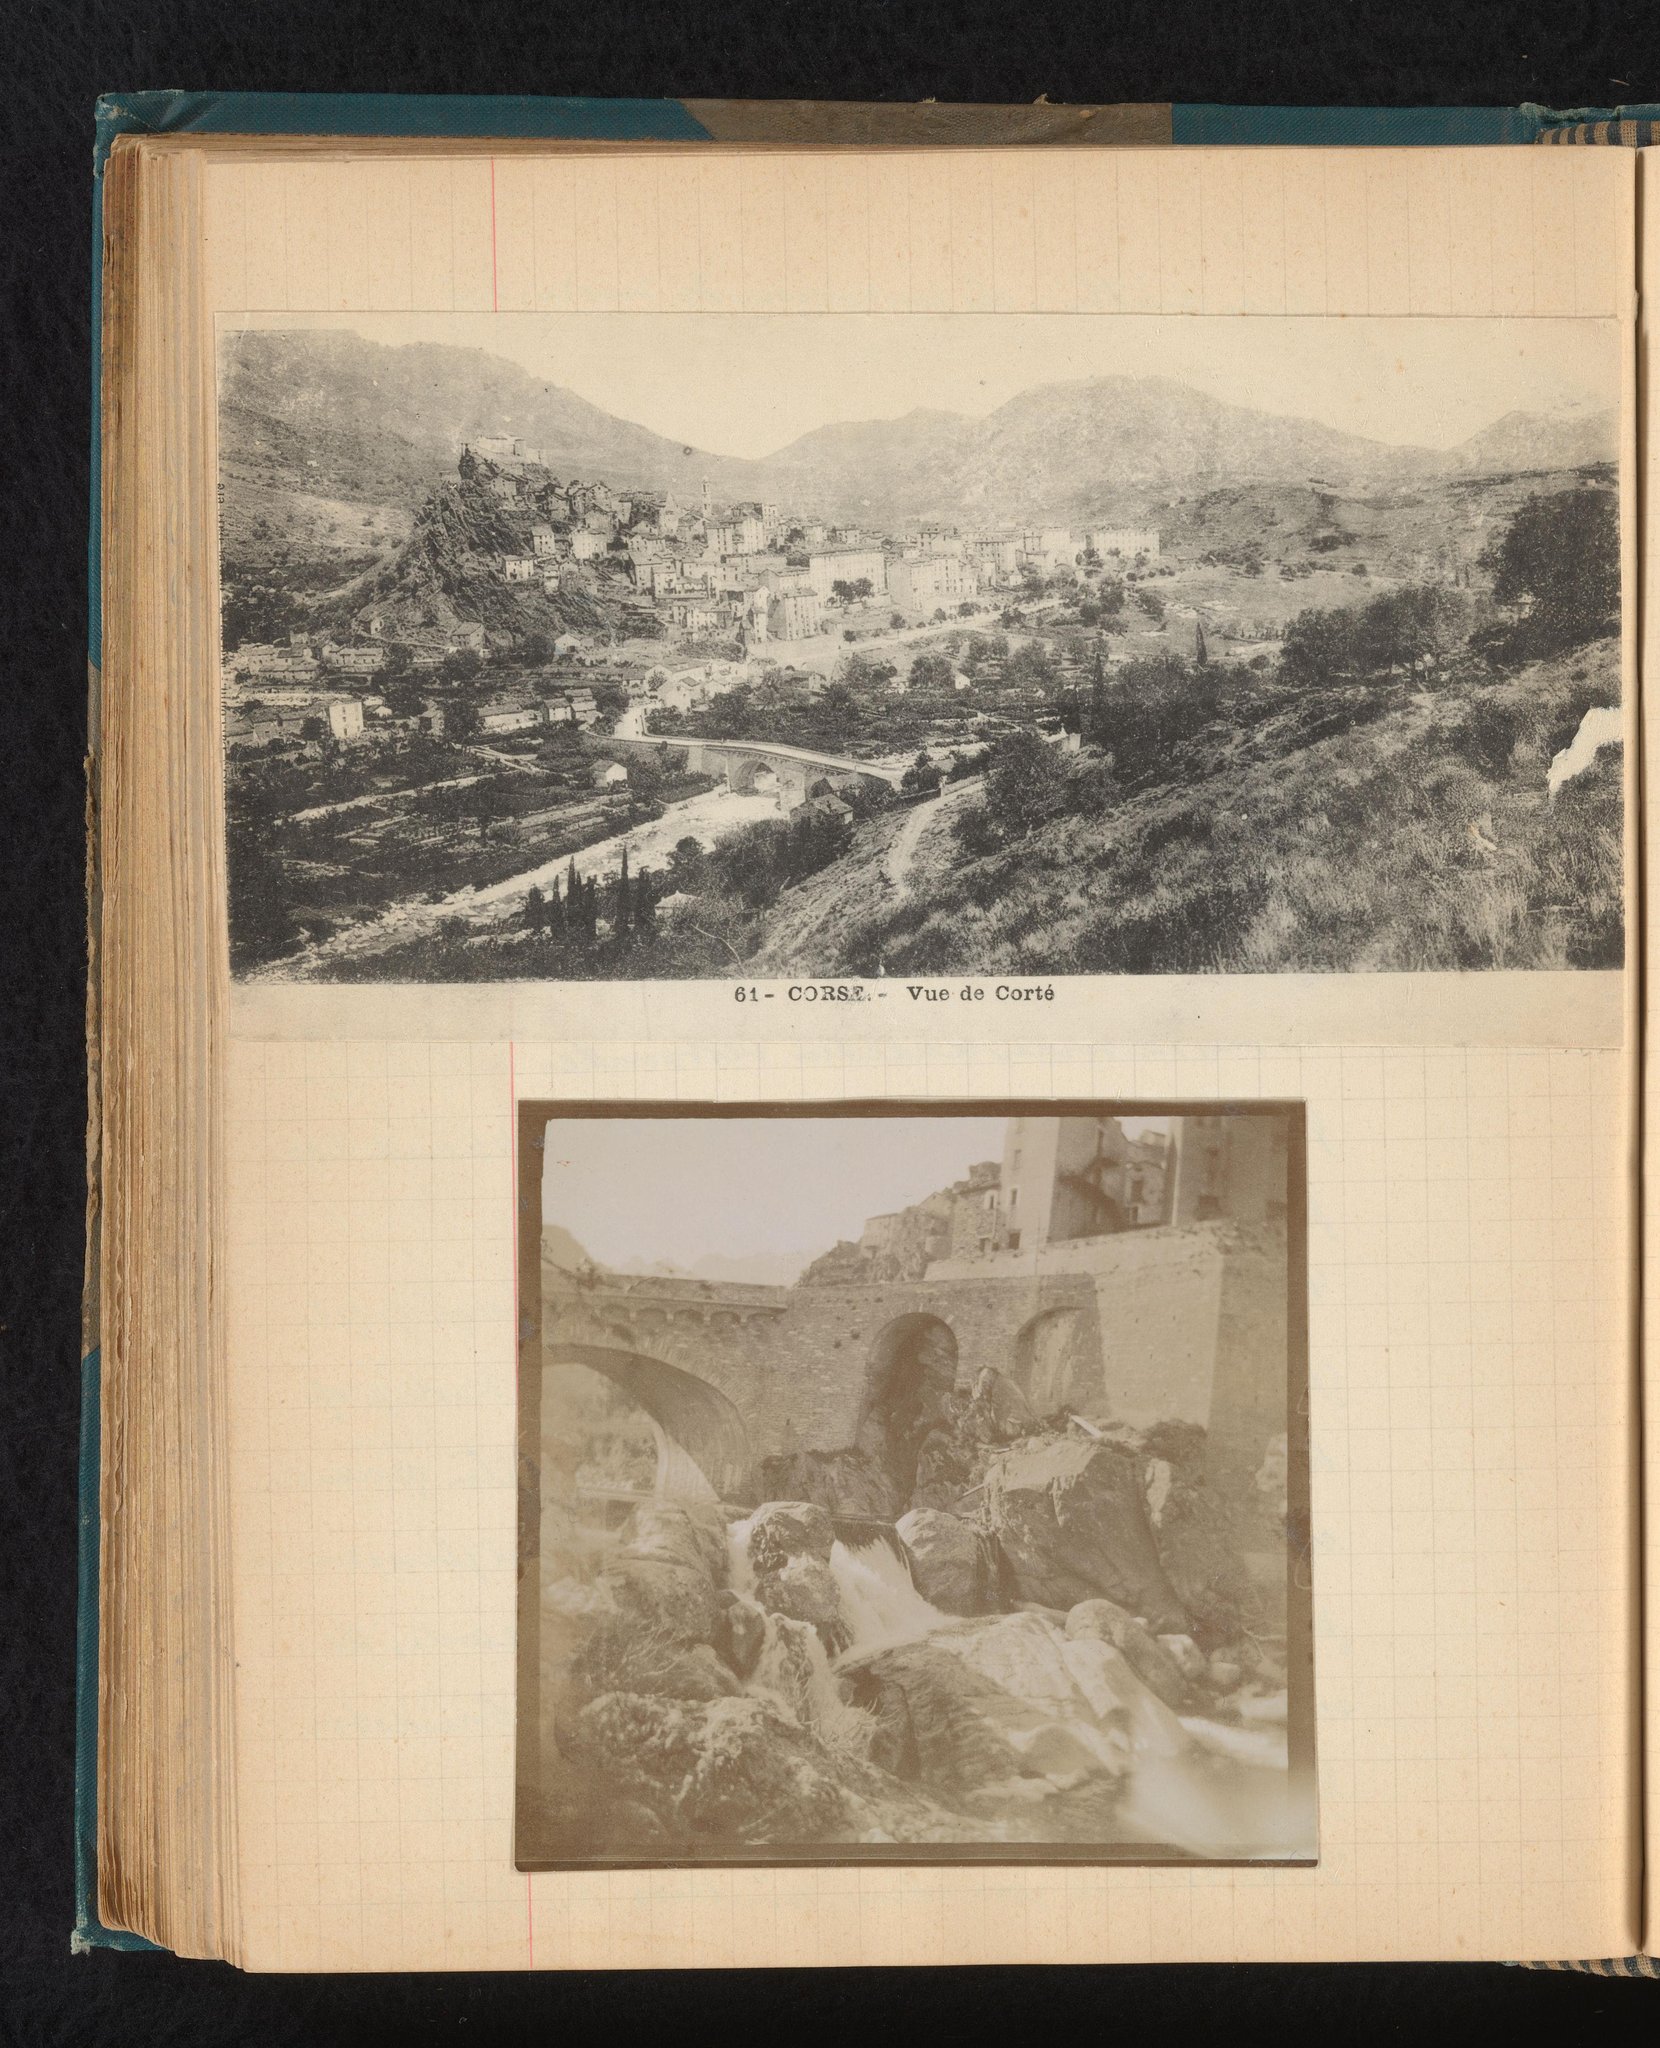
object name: album leaf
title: Uitzicht op Corté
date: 1902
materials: paper, cardboard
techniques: photograph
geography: corte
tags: city-view, and landscape with man-made constructions, rocks, bridge in village across river, canal, etc., mountains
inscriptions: inscription: ‘61 - CORSE. - Vue de Corté’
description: Deze fotomechanische afdruk en foto maken deel uit van een album.